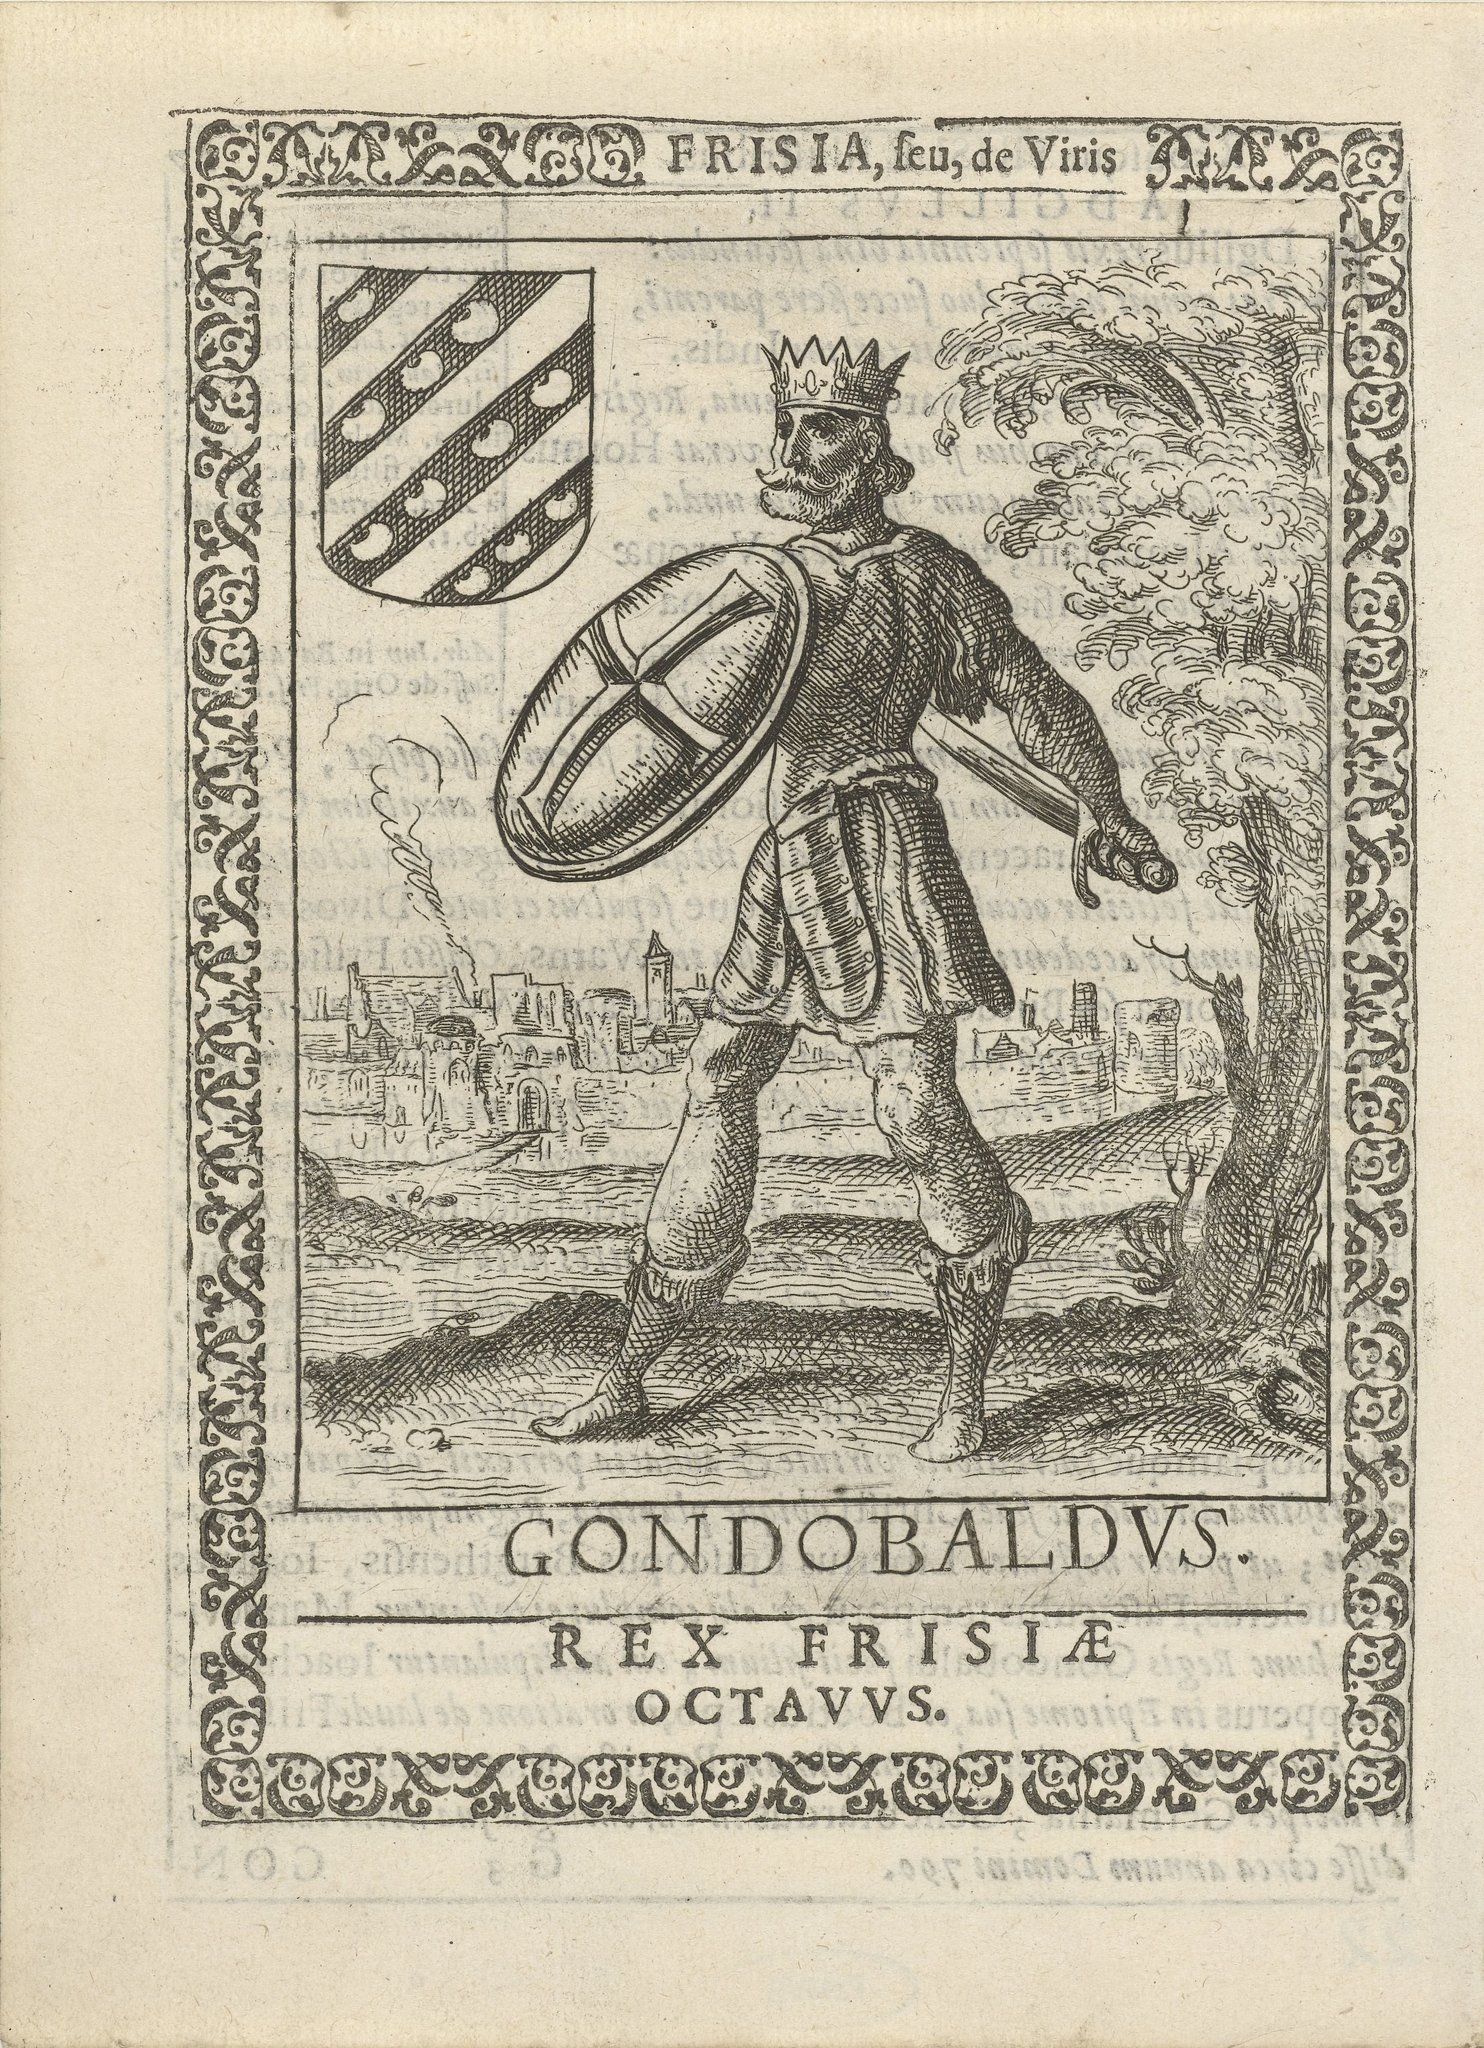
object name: print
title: Koningen en Potestaten van Friesland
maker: pieter feddes van harlingen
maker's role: painter, print maker, publisher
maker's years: 1586-1623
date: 1618-1620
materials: paper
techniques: etching, letterpress printing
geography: friesland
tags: ruler, sovereign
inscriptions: collector's mark: Lugt 2228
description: Gondobaldus (of Gundebold of Adgillis III) achtste koning der Friezen. Staande ten voeten uit, zwaard en schild in de hand. Op de achtergrond een ommuurde stad. Illustratie, met tekst op achterzijde, afkomstig uit het boek: Frisia seu de viris rebusque Frisiae illustribus libri duo.